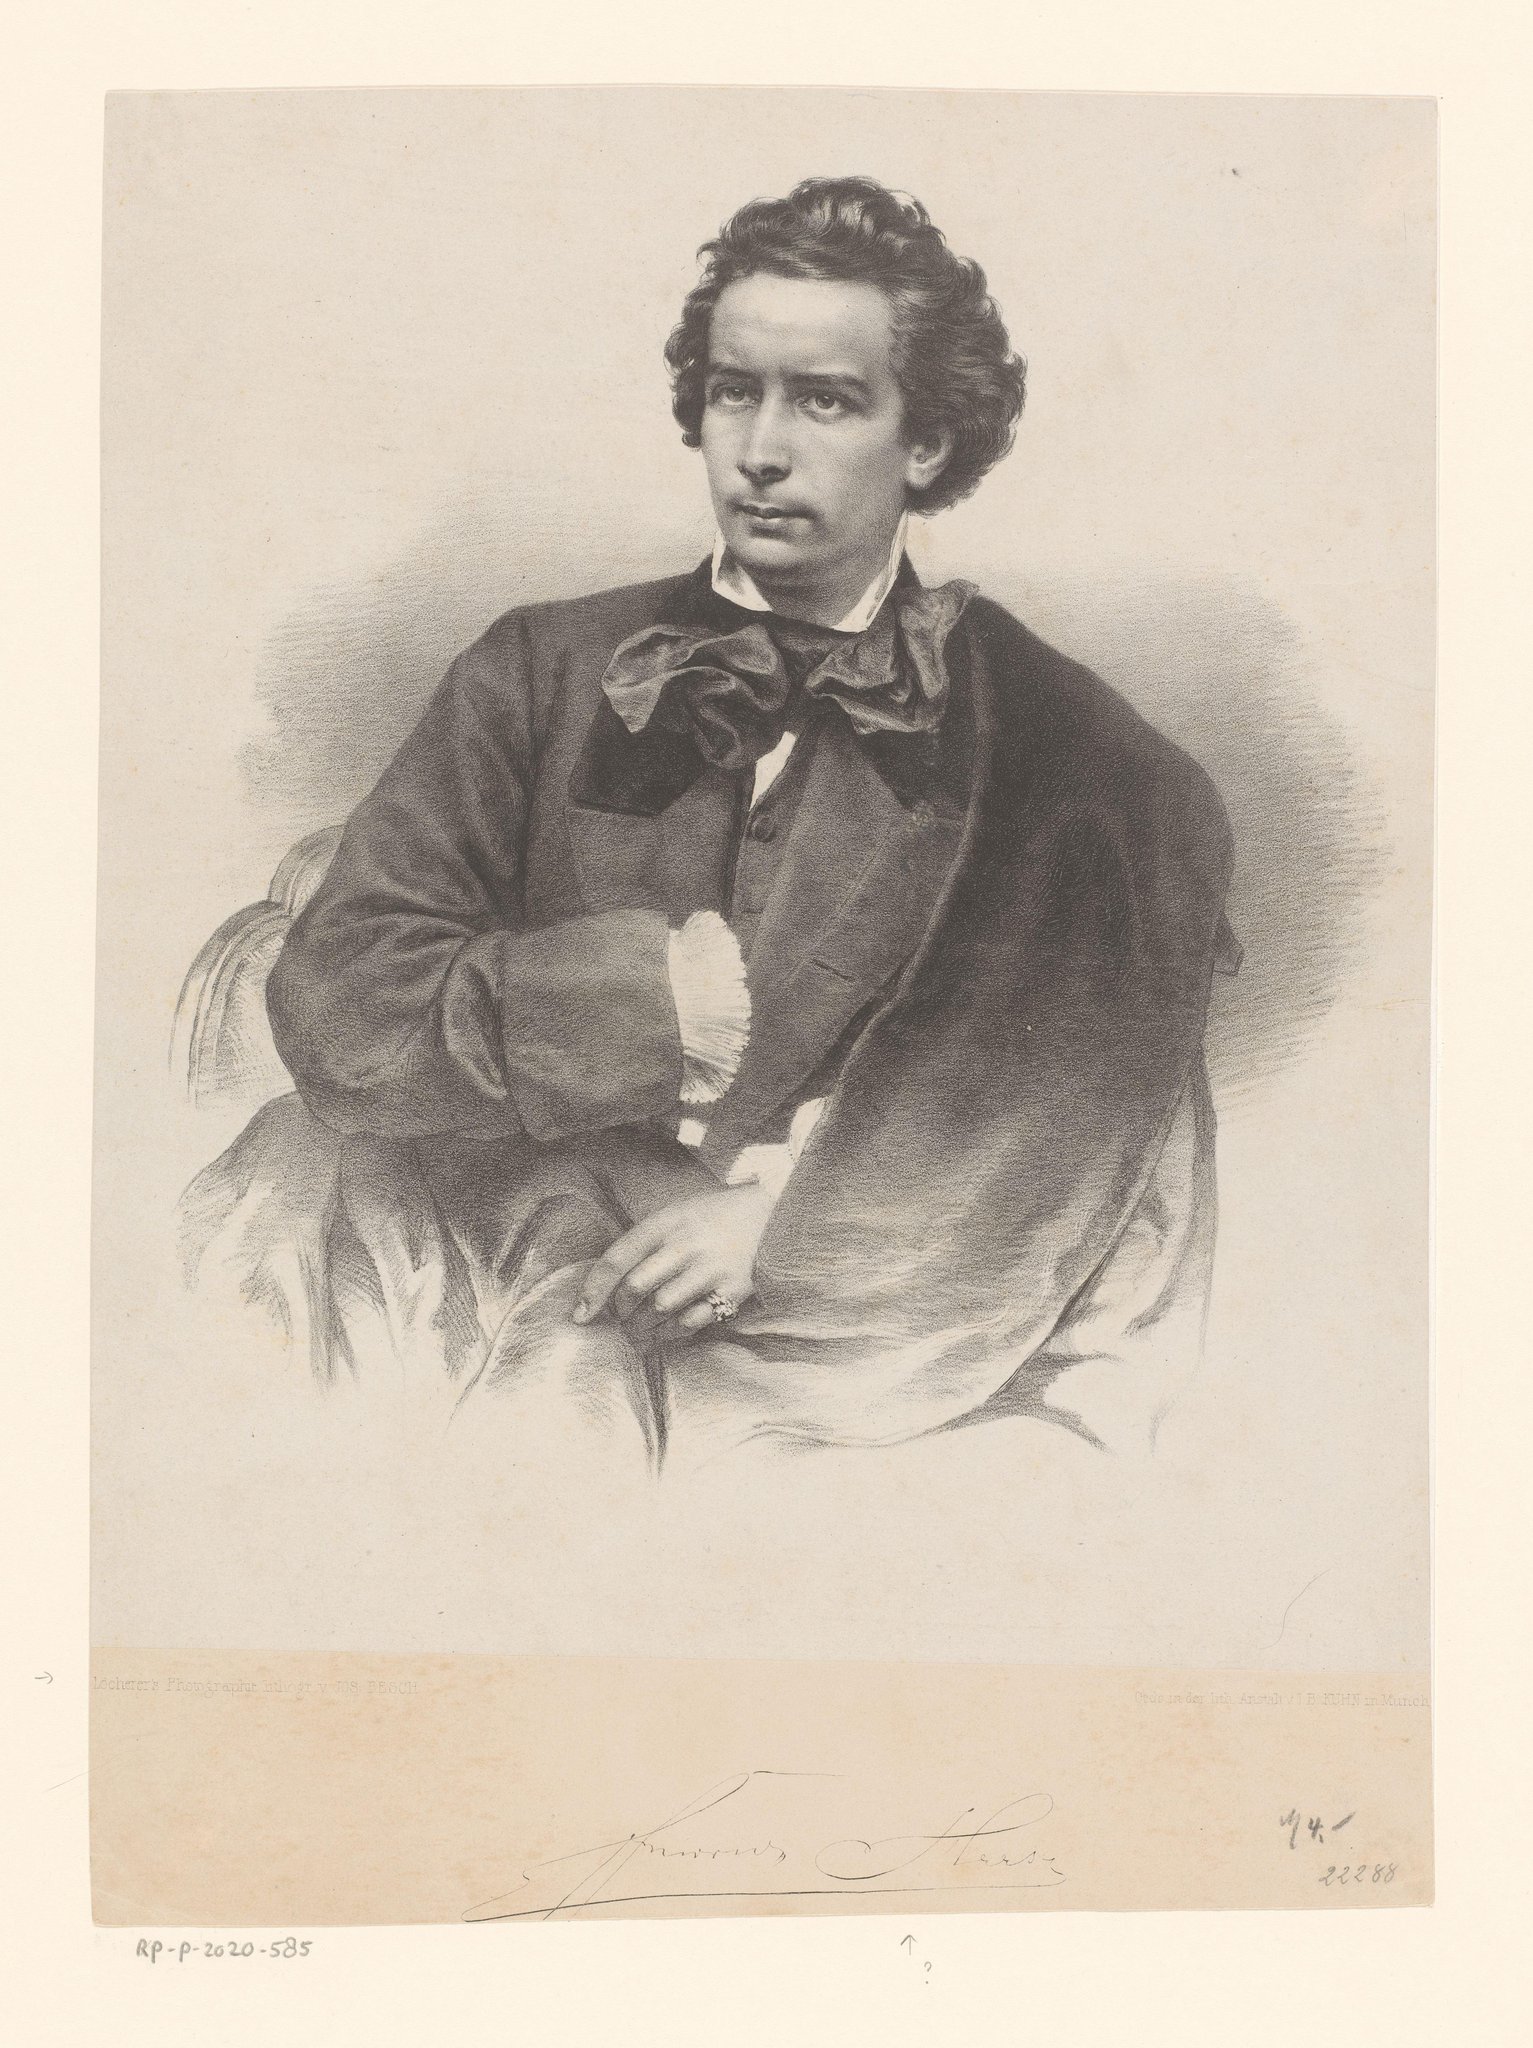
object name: print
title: [...] Herse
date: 1840-1861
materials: paper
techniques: lithograph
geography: munich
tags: historical persons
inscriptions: collector's mark: Lugt 4100, collector's mark: Lugt 2228